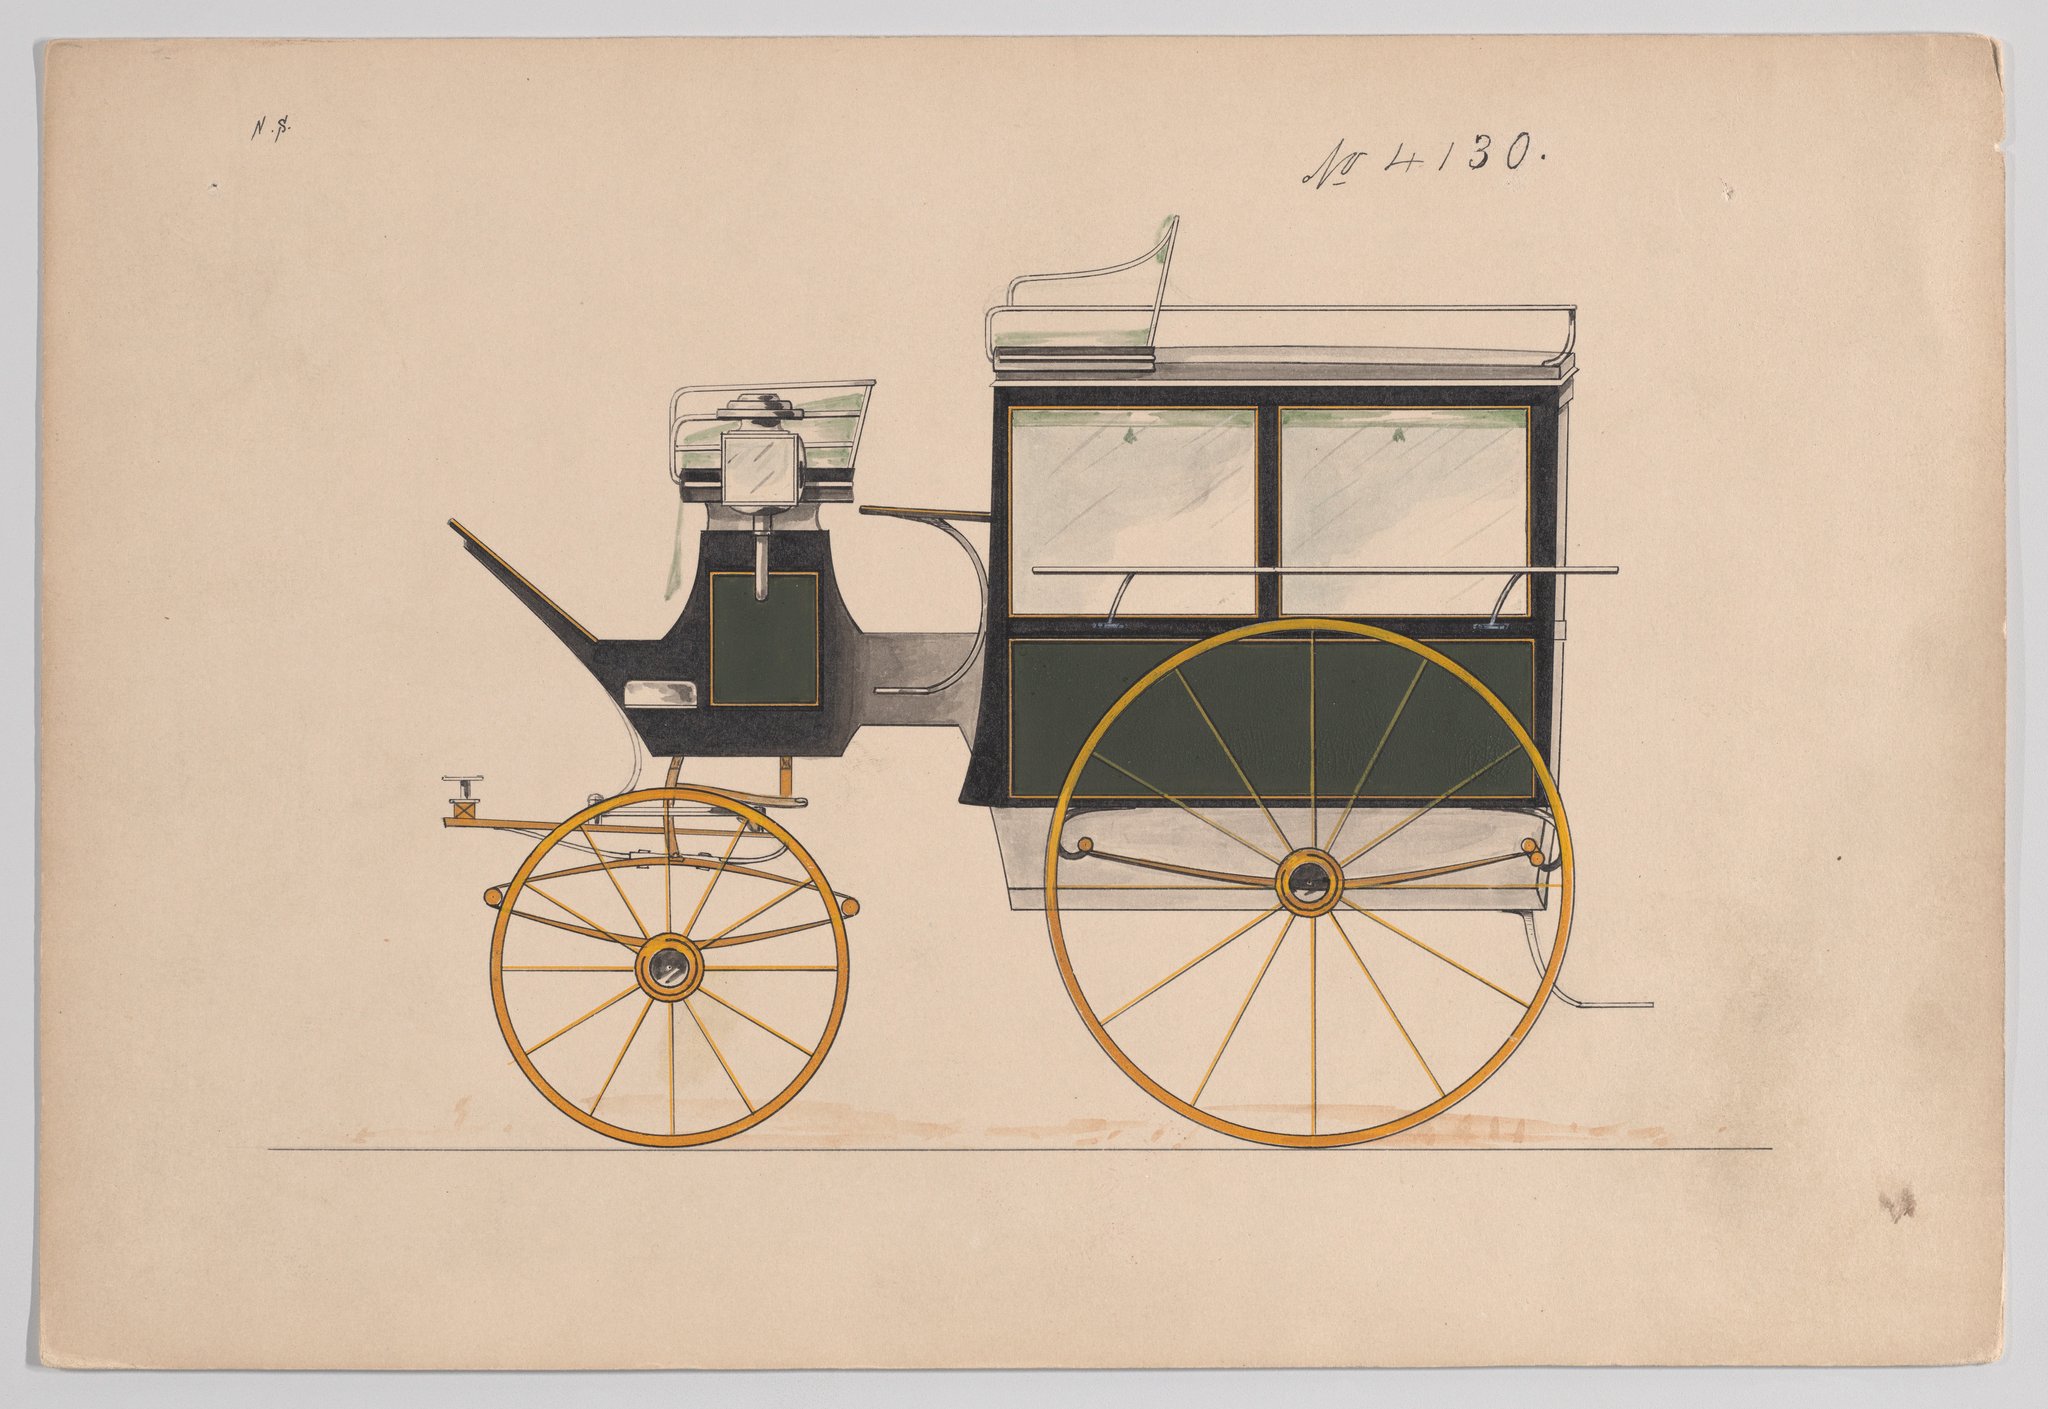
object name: drawing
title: Design for Omnibus or Wagonette, no. 4130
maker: brewster & co.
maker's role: manufacturer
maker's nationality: american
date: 1891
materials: gouache, ink, watercolor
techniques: pen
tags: carriages